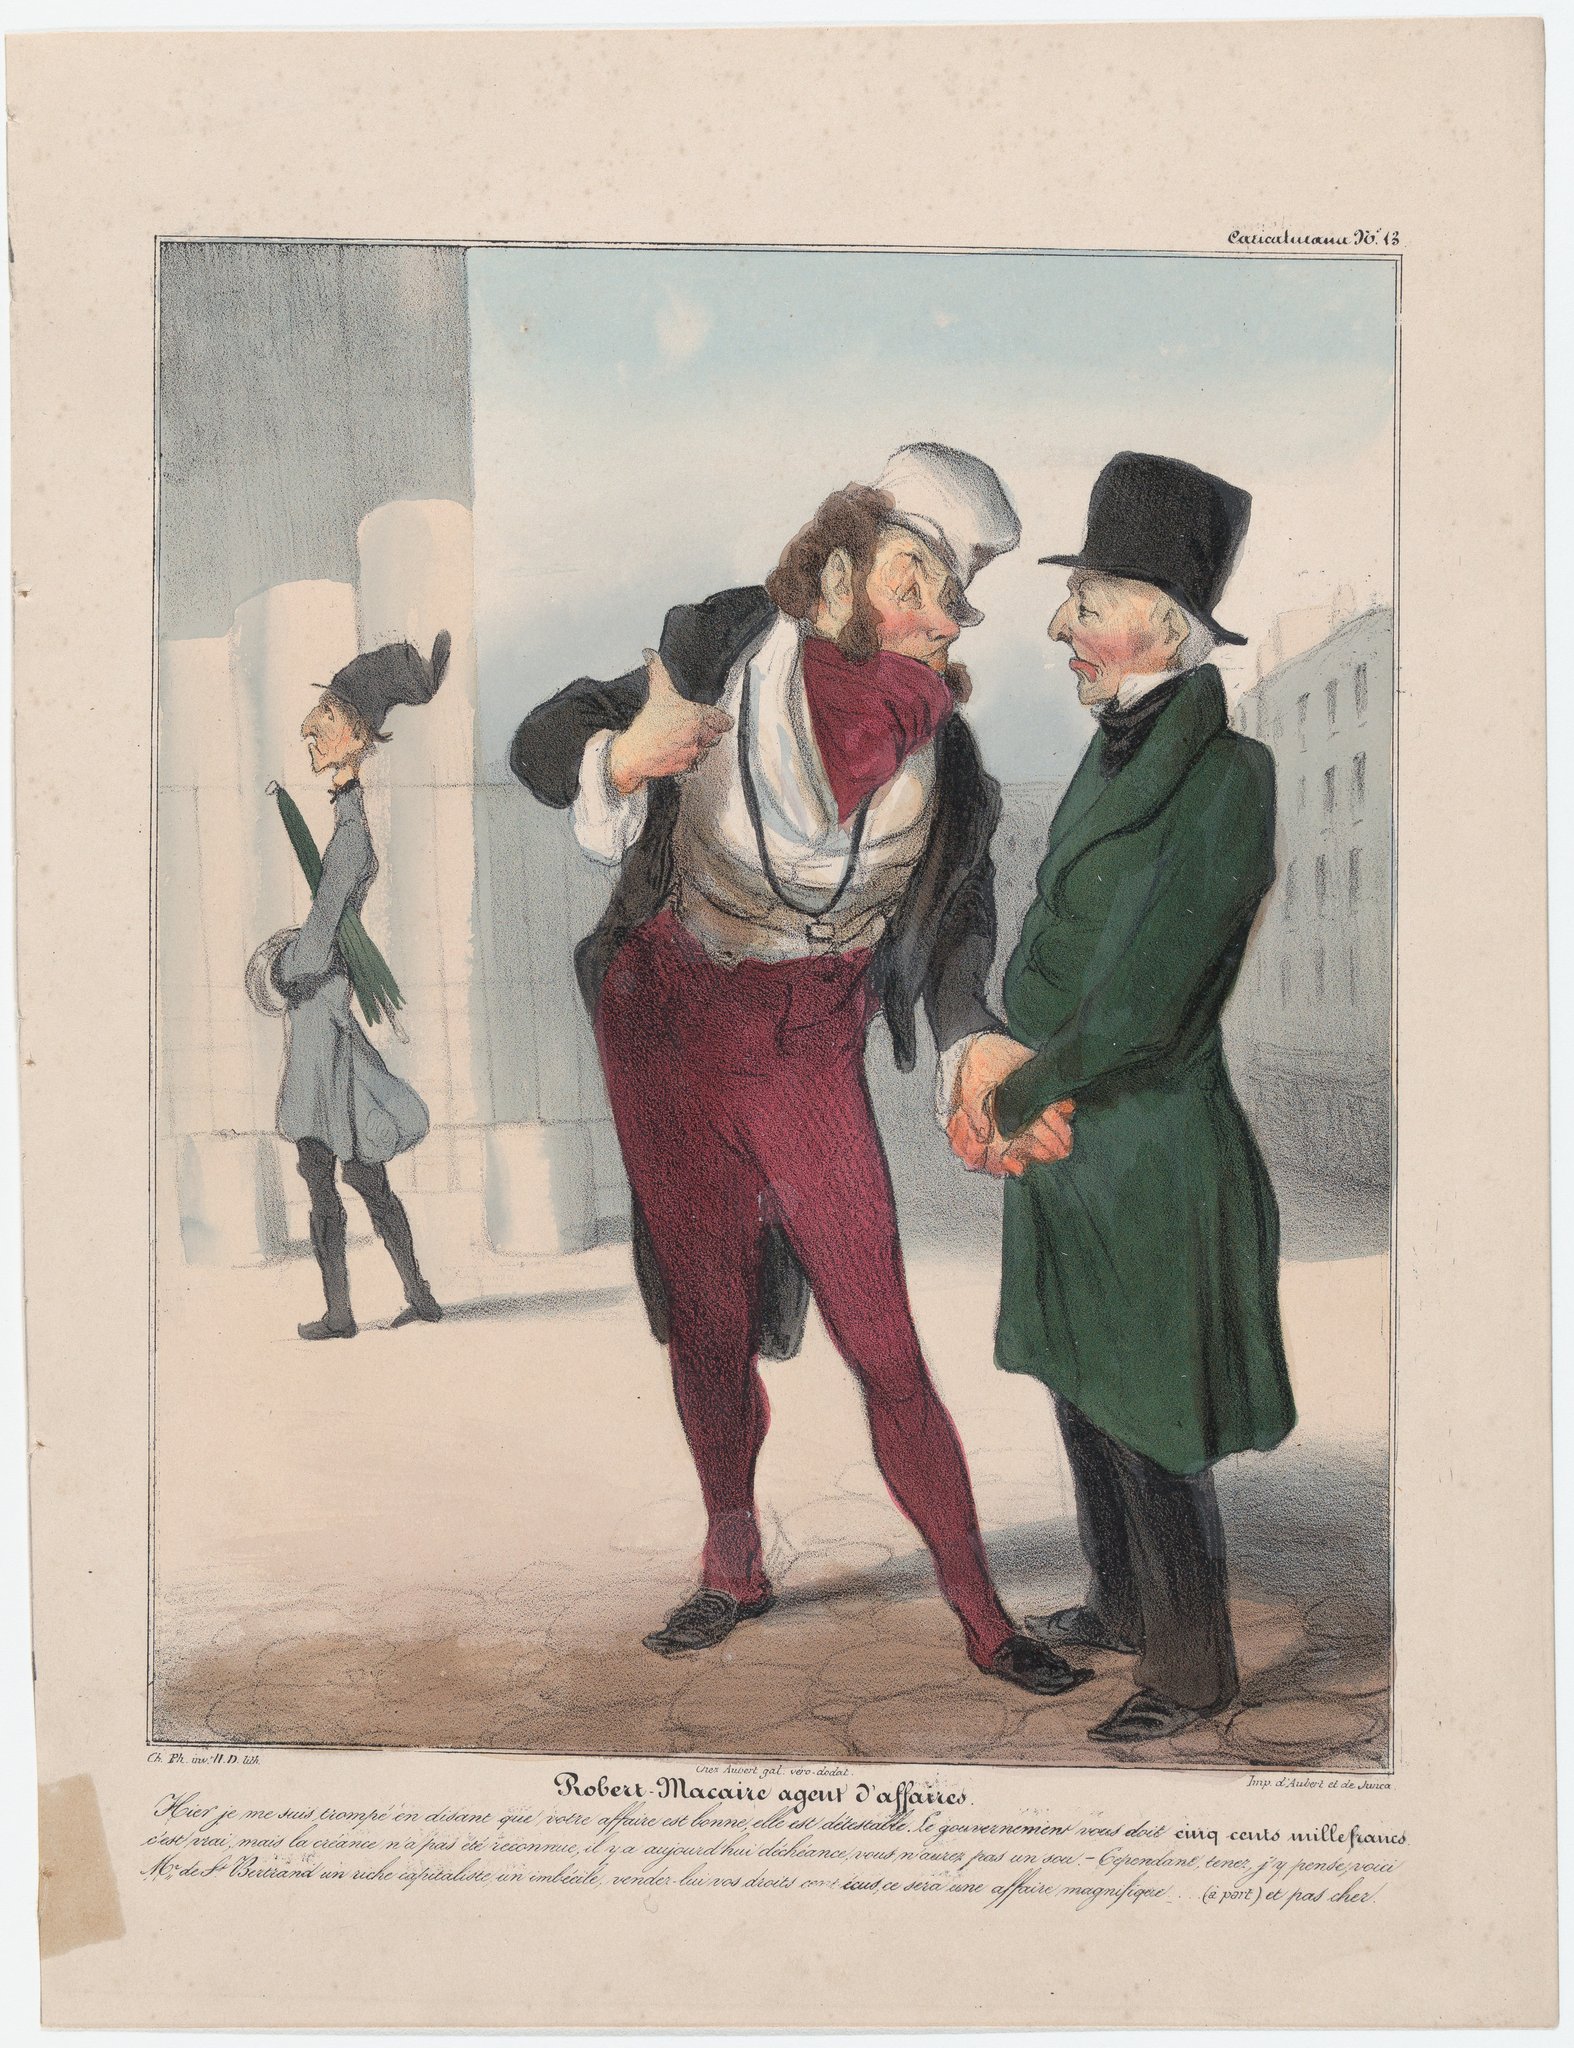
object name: print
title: Plate 13: Robert Macaire, business agent, from 'Caricaturana,' published in Les Robert Macaires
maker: honoré daumier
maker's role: artist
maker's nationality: french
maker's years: 1808-1879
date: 1838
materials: paper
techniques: lithograph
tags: satire,men